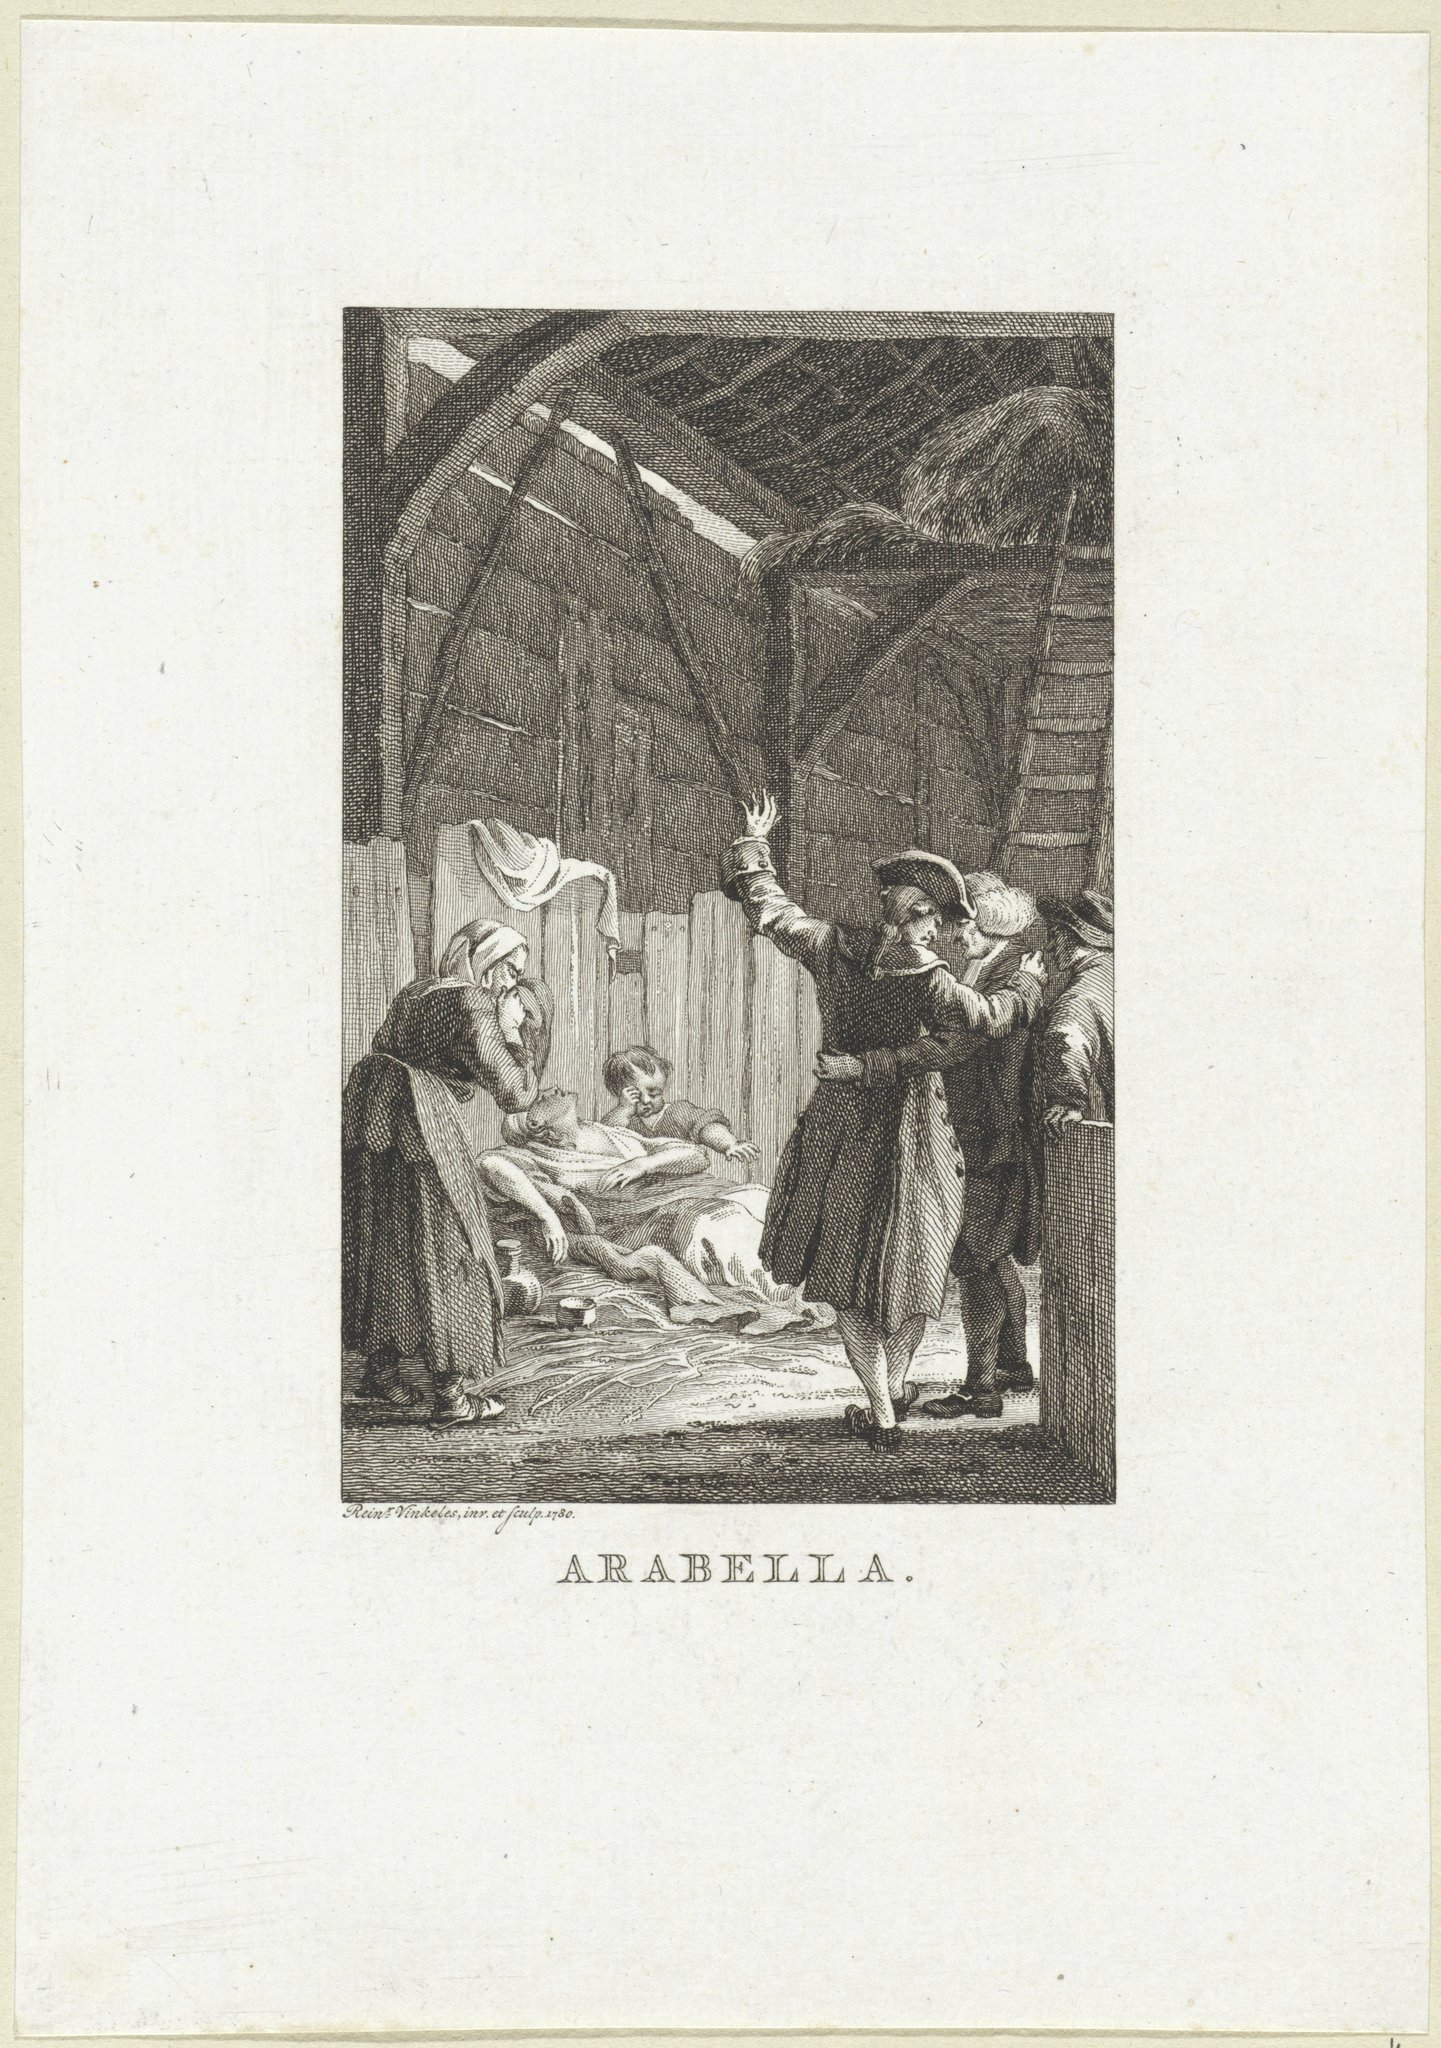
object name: print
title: Enkele figuren bij een dode vrouw in een schuur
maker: reinier vinkeles (i)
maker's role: draughtsman, print maker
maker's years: 1741-1816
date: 1780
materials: paper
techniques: engraving, etching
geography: amsterdam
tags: barn, weeping, death of human being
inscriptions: collector's mark: Lugt 240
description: Deze prent is ook gebruikt als illustratie bij het verhaal 'Arabella' voor: Baculard d'Arnaud, F.T.M. de. Zedelijke verhaalen, deel 5. Amsterdam: A. Mens Jansz. en A.E. Munnikhuisen, 1780.